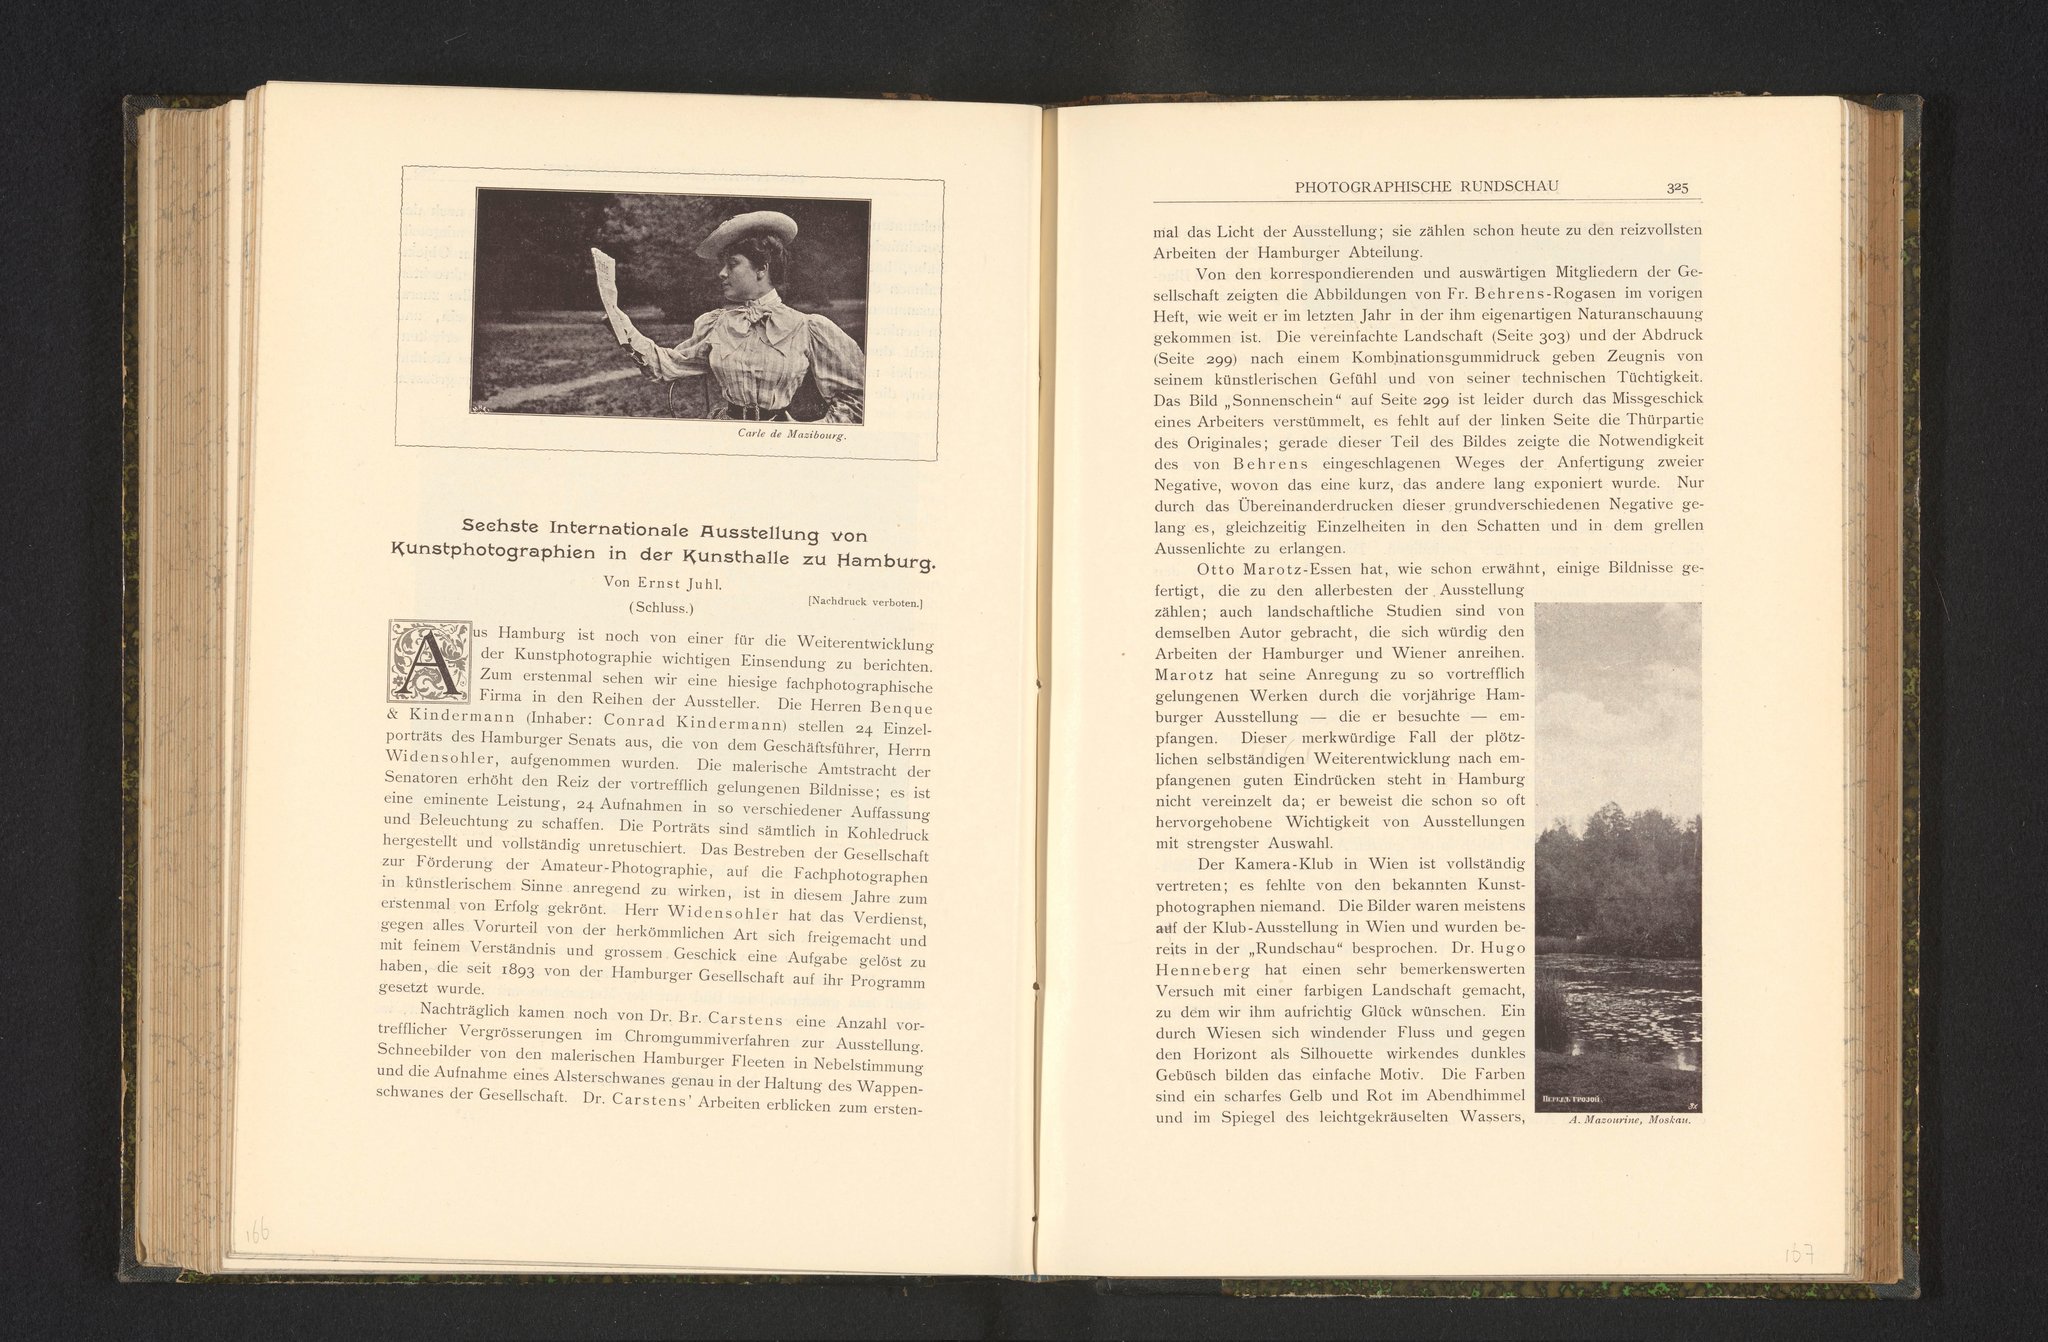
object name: page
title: Gezicht op een water aan een bos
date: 1893-1898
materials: paper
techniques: autotype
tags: trees, landscapes with waters, waterscapes, seascapes (in the temperate zone)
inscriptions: monogram: ‘BX’